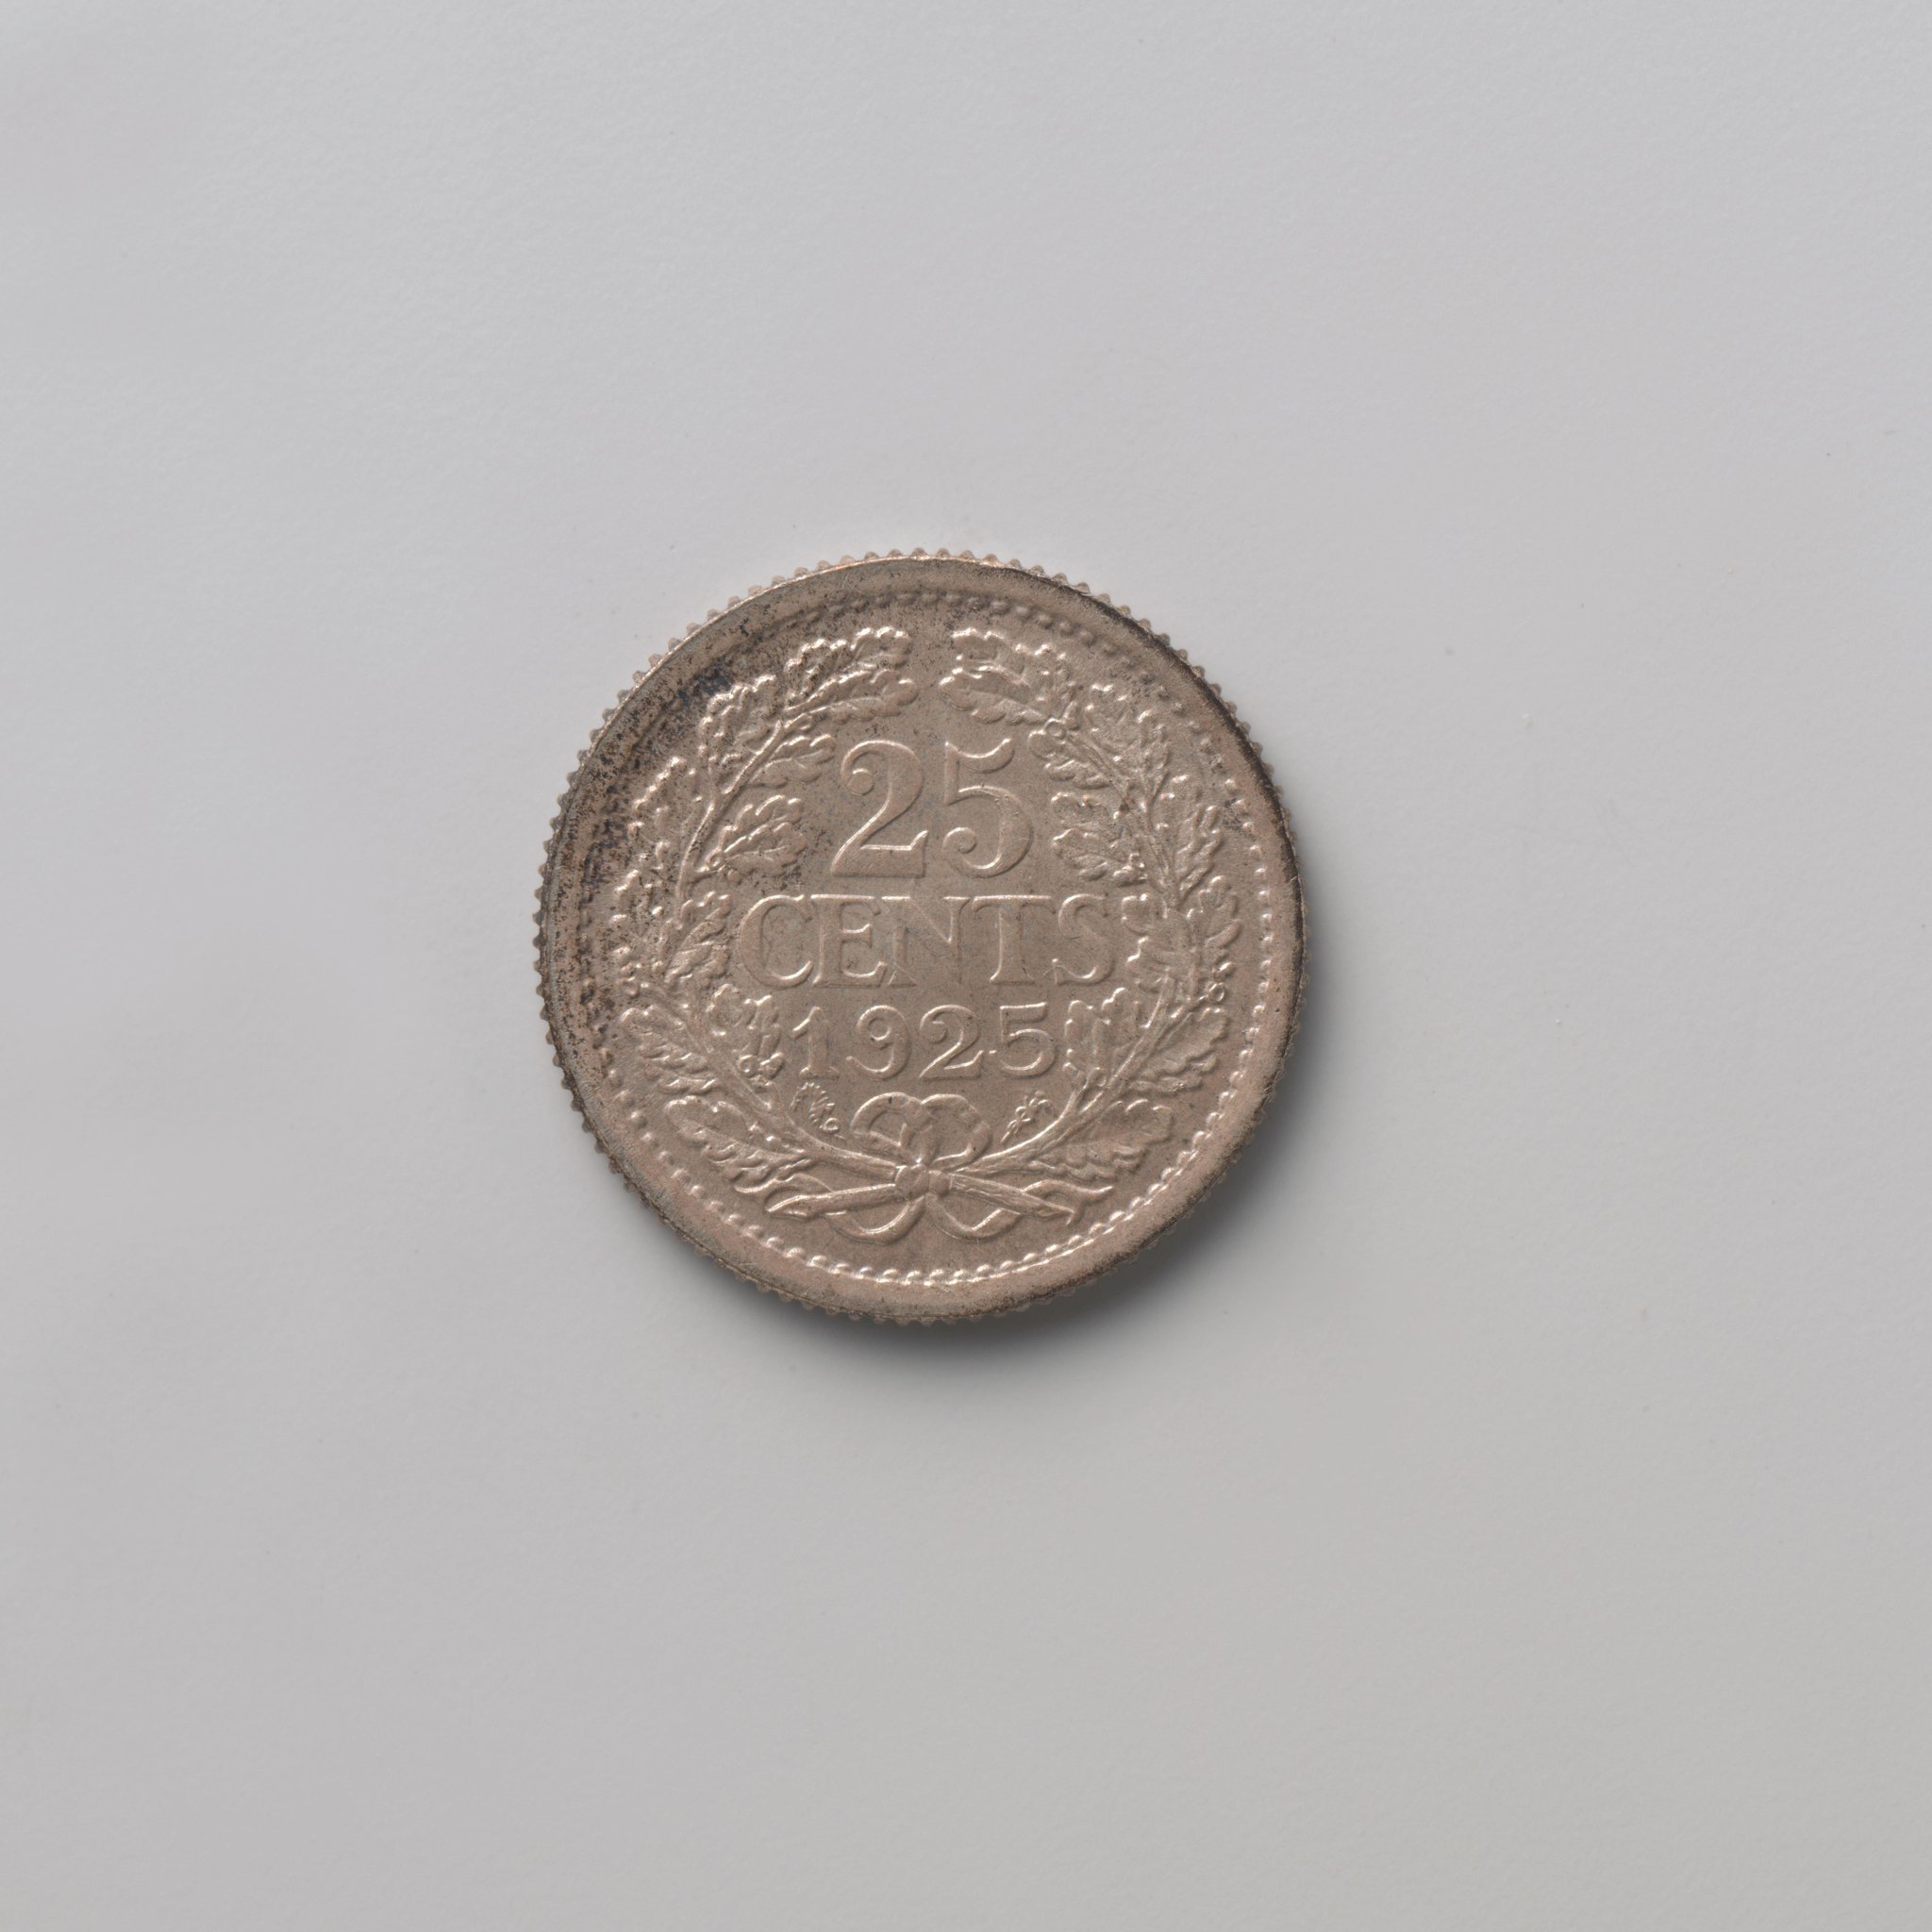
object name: vijfentwintig cent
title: Nederland, 25 cent,1925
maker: wilhelmina of the netherlands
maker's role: print maker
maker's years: 1880-1962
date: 1925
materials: silver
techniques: striking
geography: utrecht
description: Zilveren munt. Voorzijde: gedrapeerd borstbeeld naar links. Keerzijde: binnen twee samengebonden eiketakken waarde-aanduiding 25 cents en jaartal. Kartelrand.